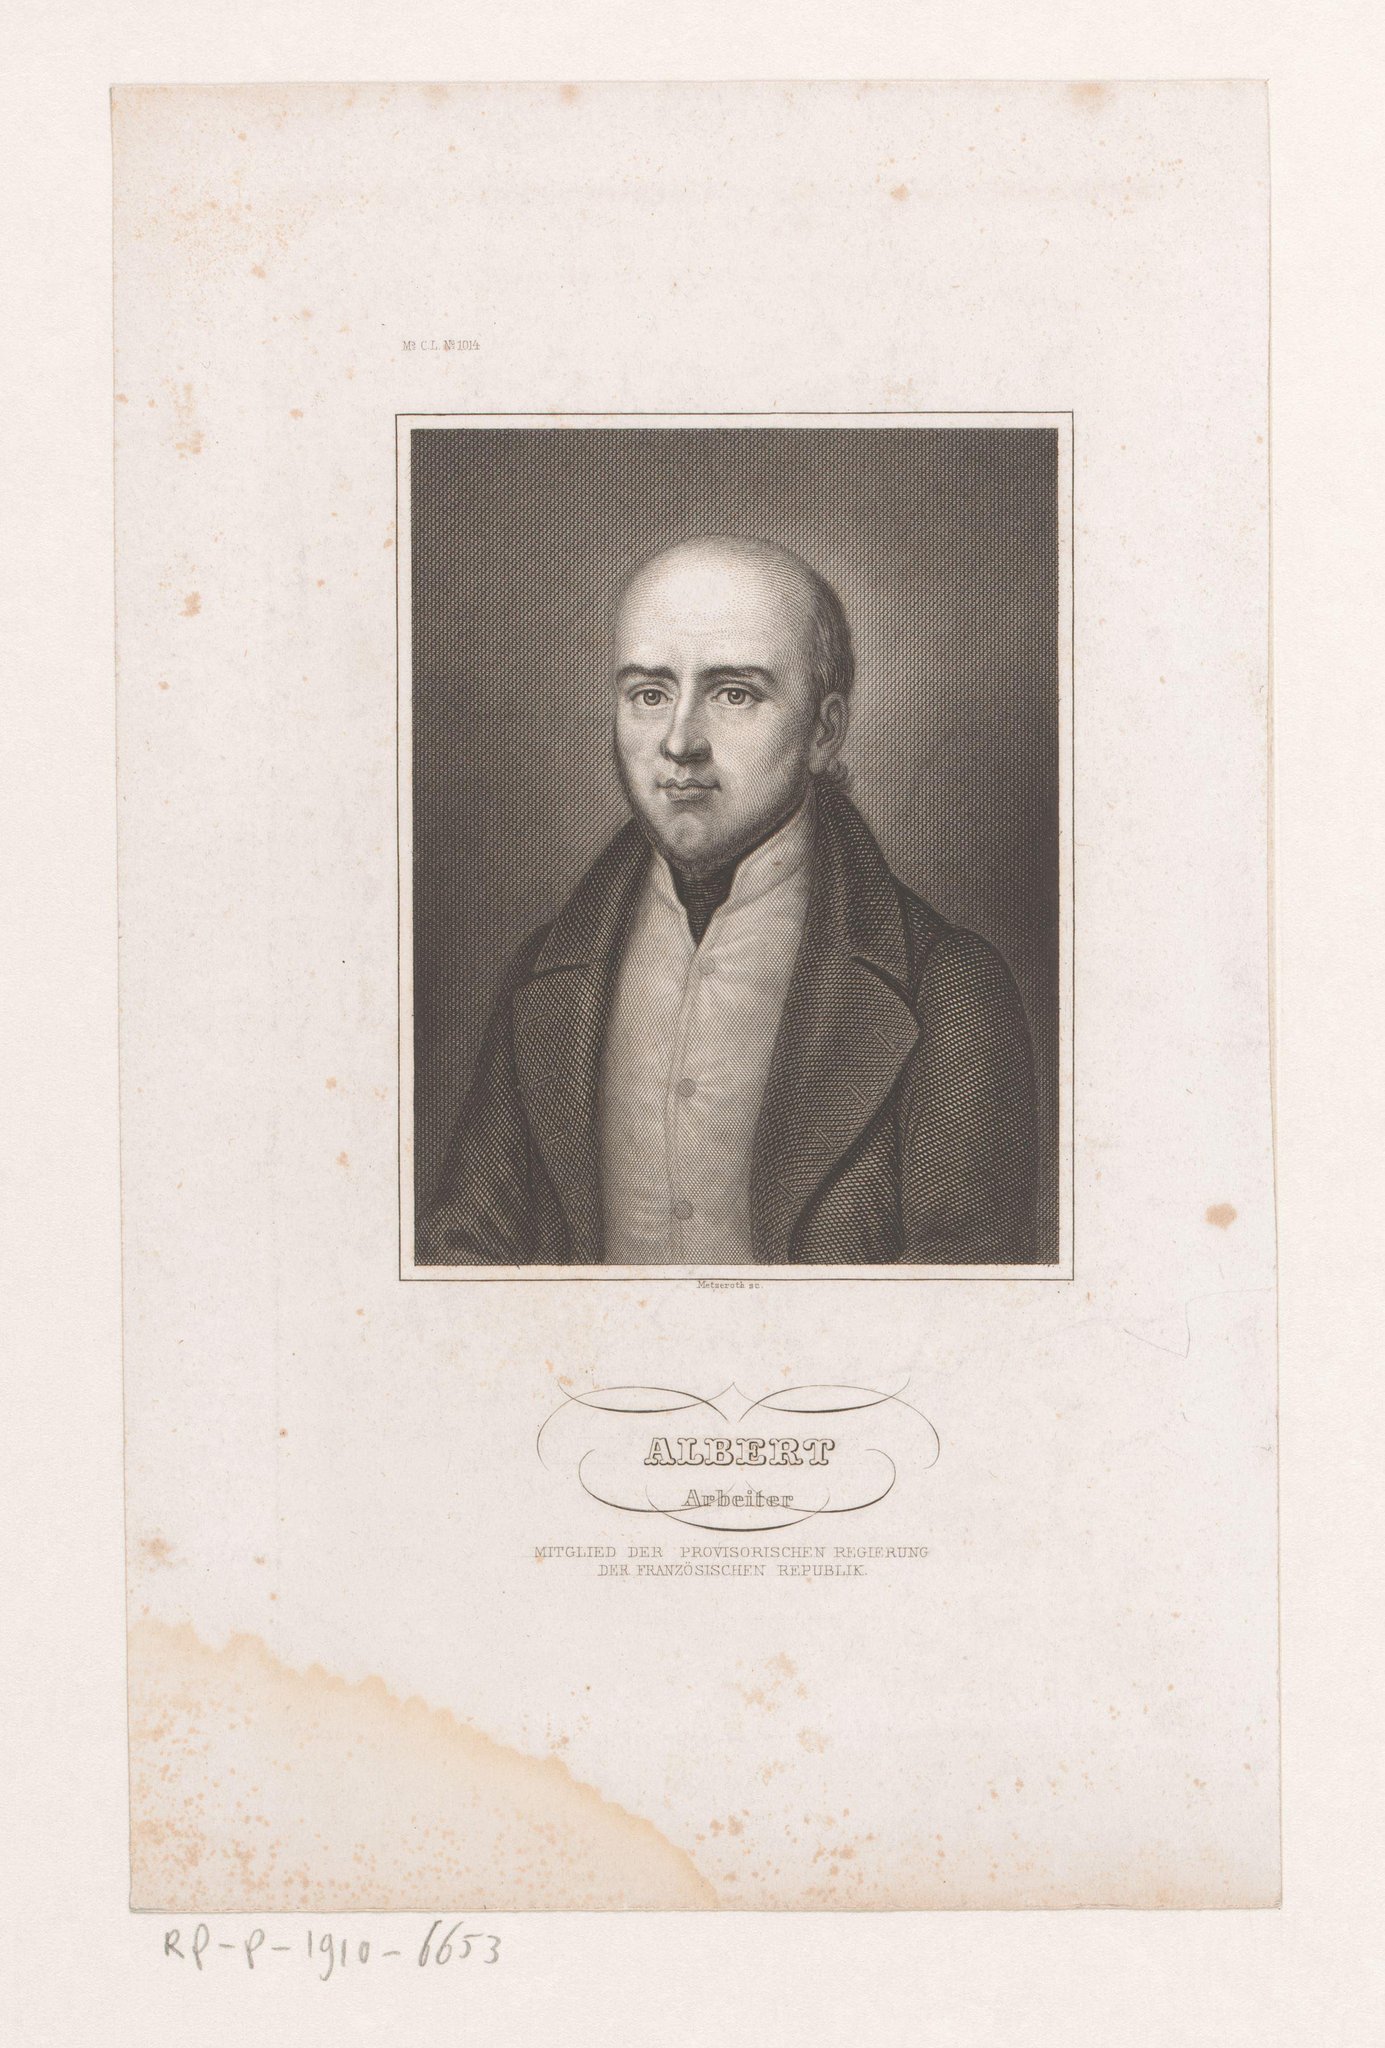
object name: print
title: Portret van Alexandre-Albert Martin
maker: g. metzeroth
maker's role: print maker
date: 1840-1855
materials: paper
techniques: engraving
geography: germany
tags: politician, historical persons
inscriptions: collector's mark: Lugt 2228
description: Prent afkomstig uit: Conversations-Lexikon für die gebildeten Stände, voor het eerst uitgegeven tussen 1840-1855.